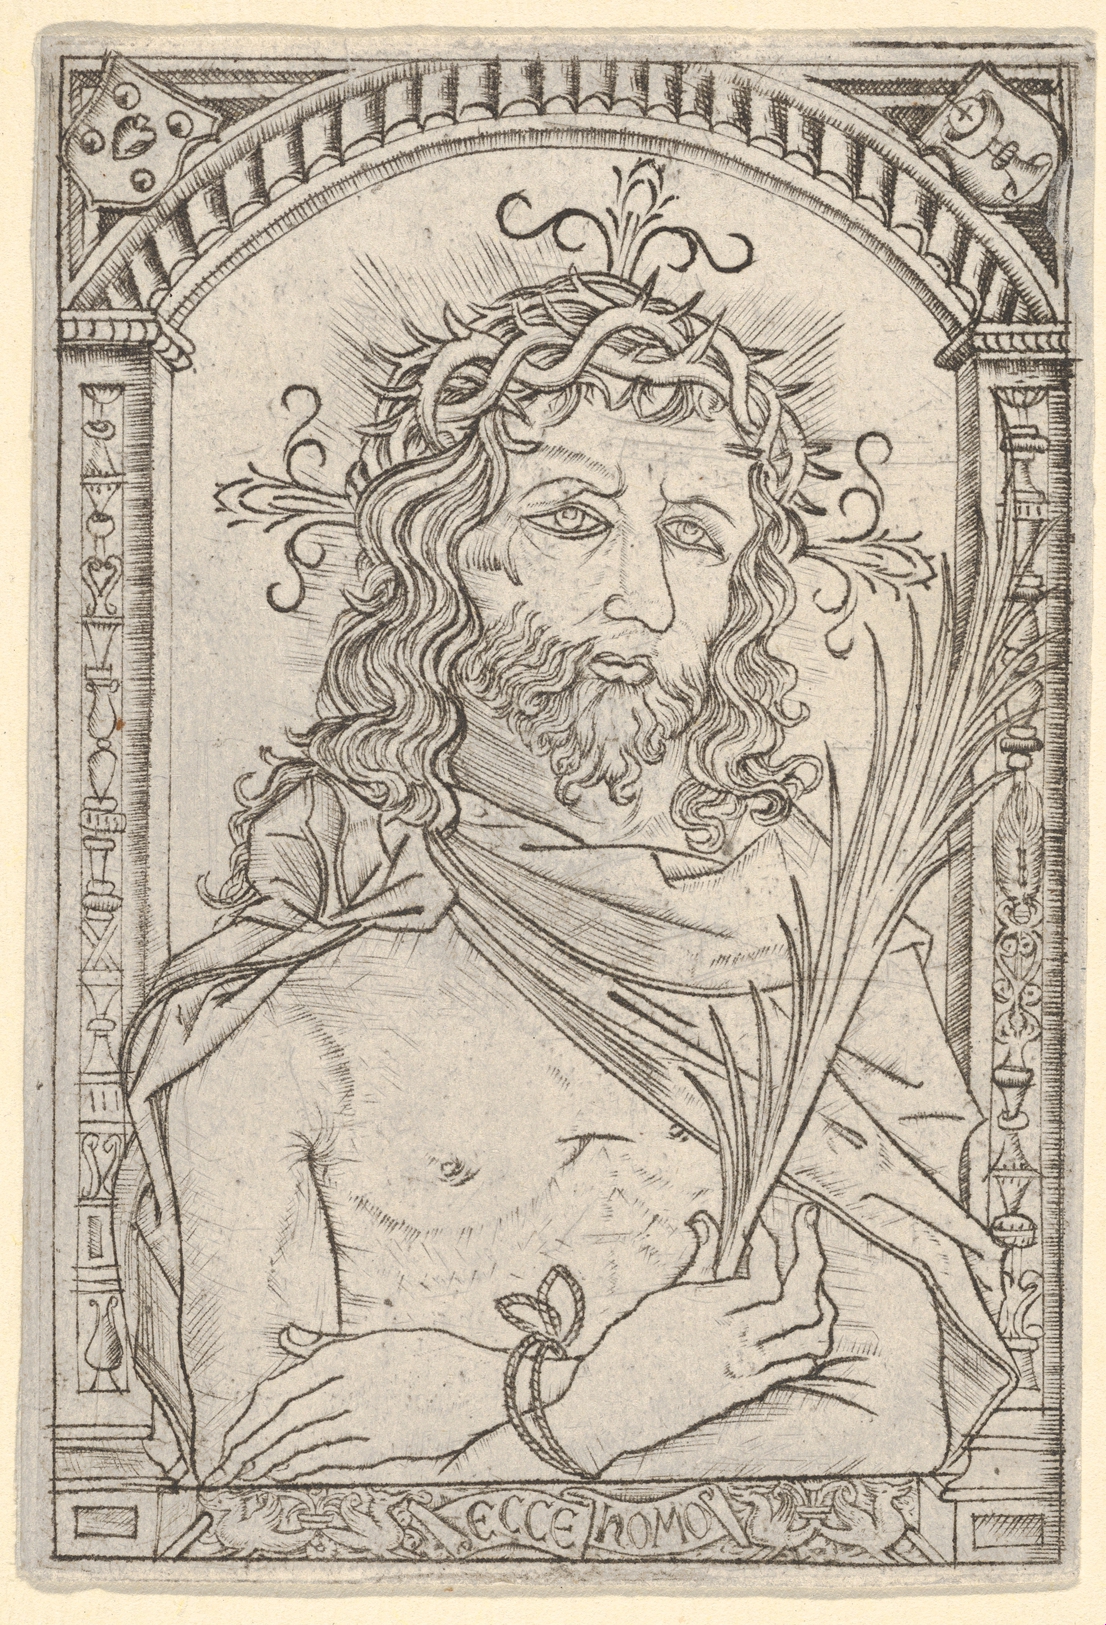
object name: print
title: Christ as the man of sorrows set within an ornate frame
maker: nicoletto da modena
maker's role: artist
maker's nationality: italian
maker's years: 1500-1520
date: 1500-1520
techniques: engraving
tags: portraits,christ